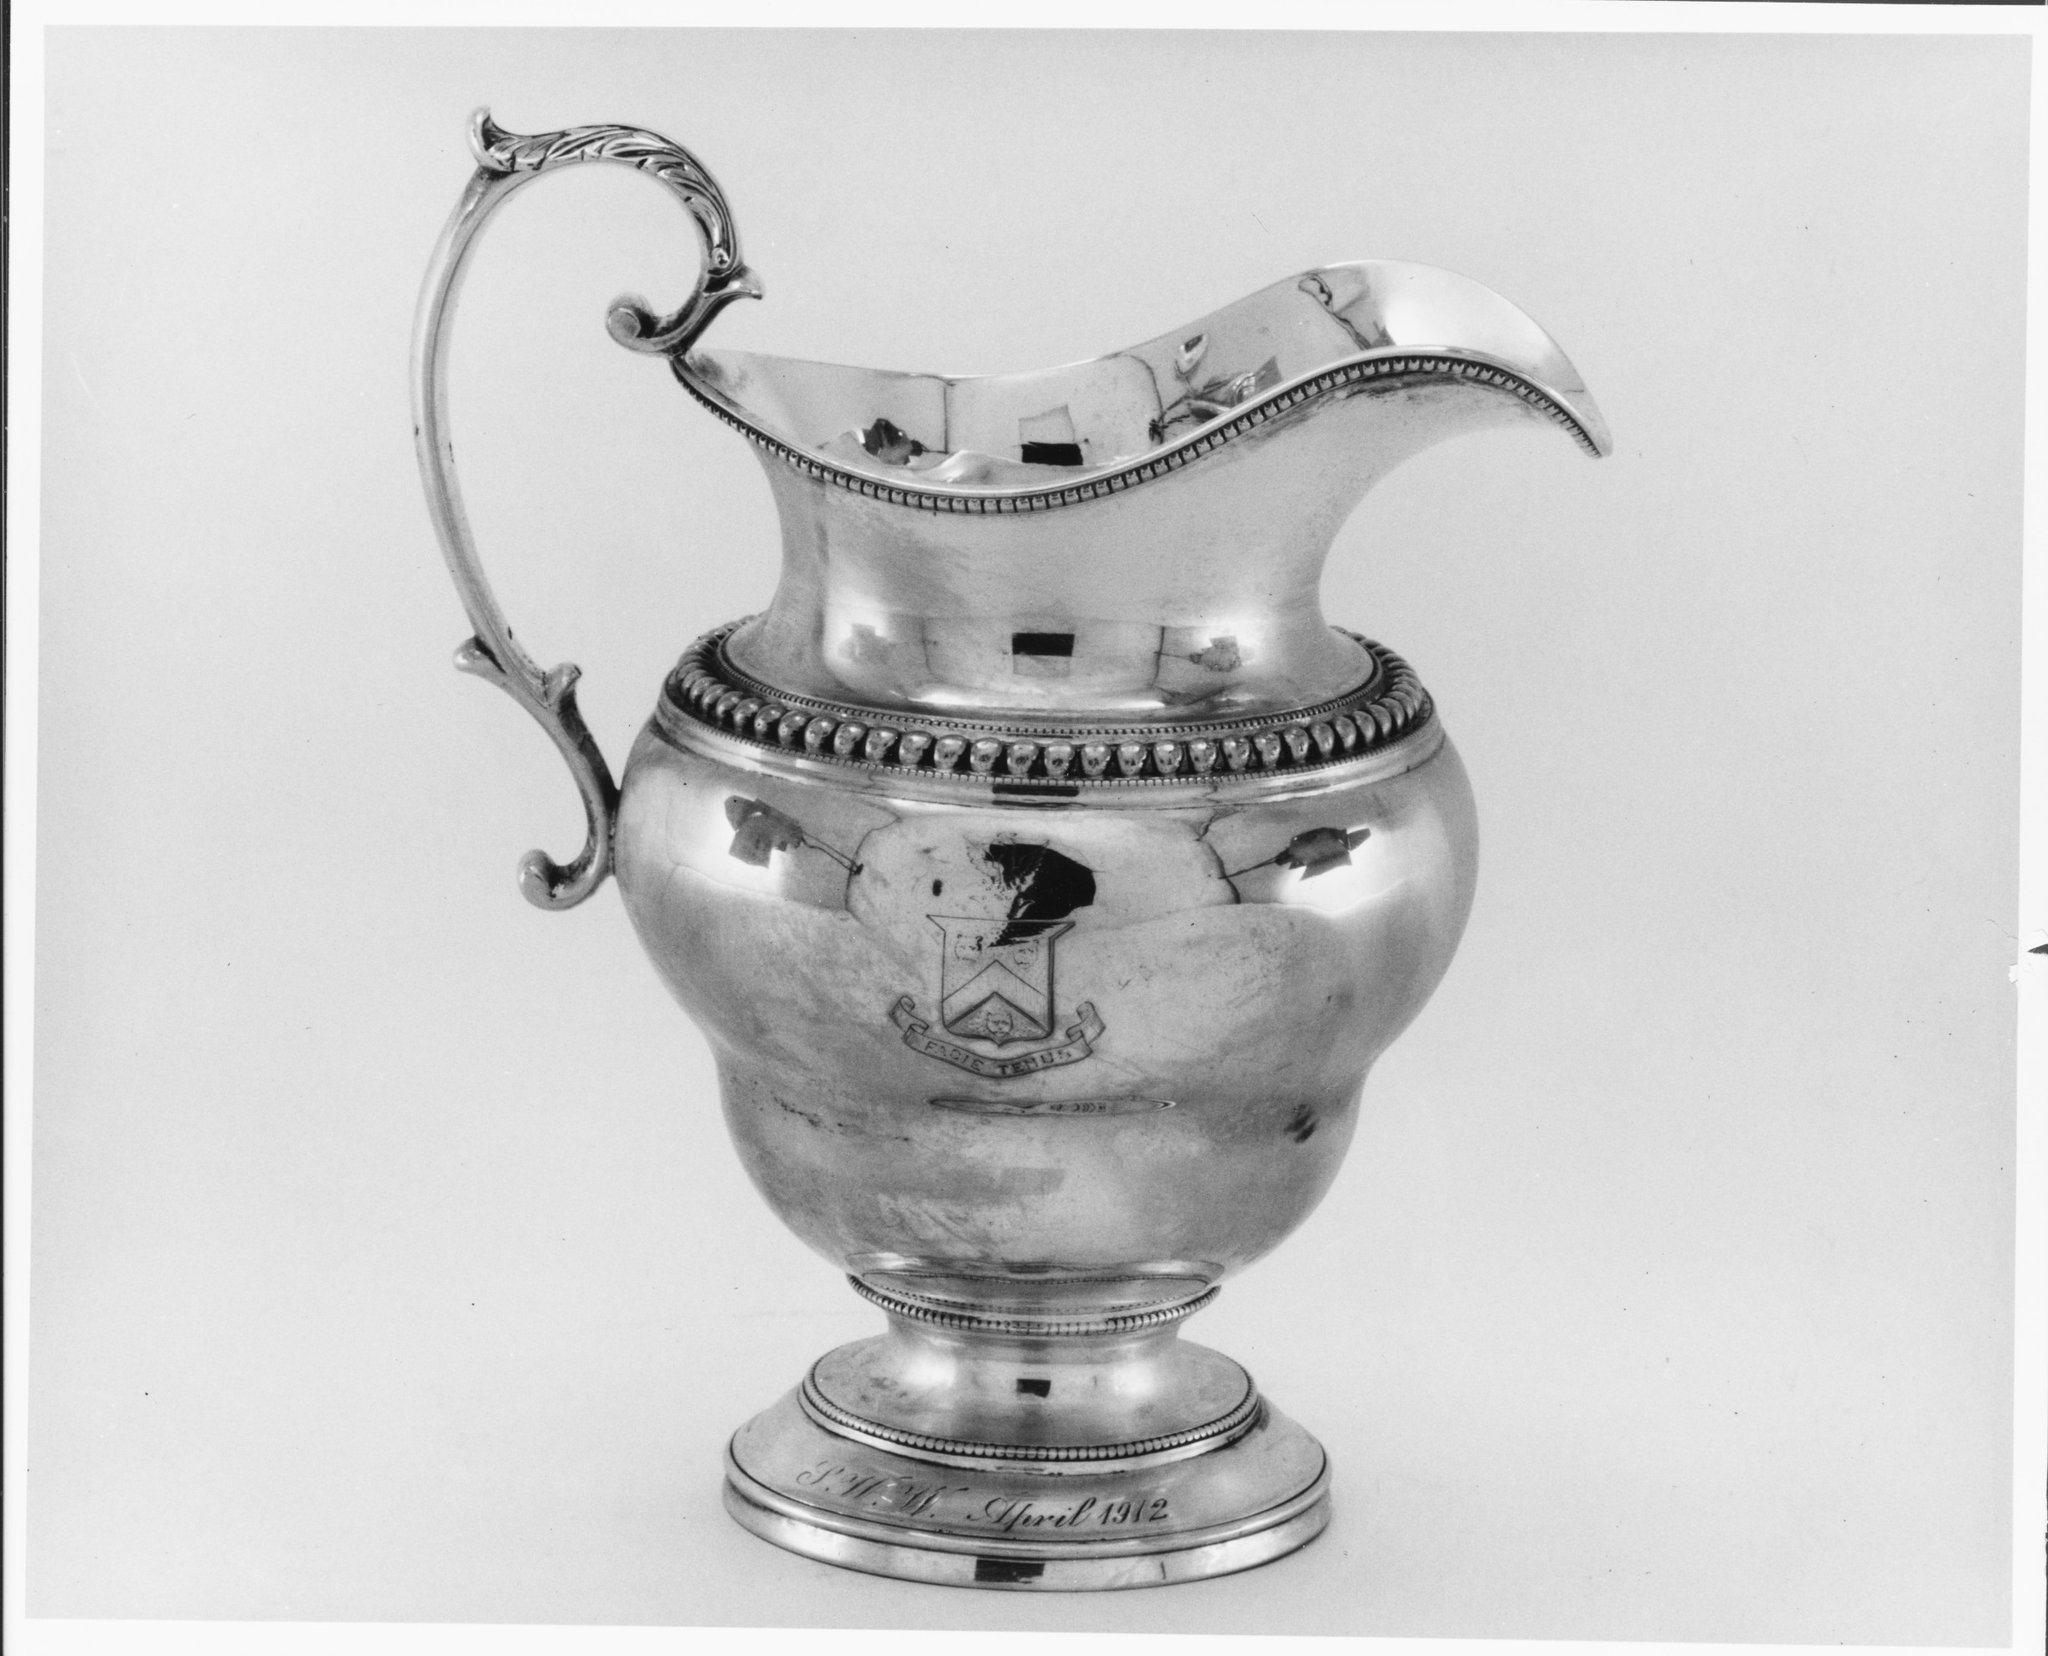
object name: cream pot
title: Creamer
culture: american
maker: harvey lewis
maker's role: maker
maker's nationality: american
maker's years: 1780-1835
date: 1827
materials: silver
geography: united states